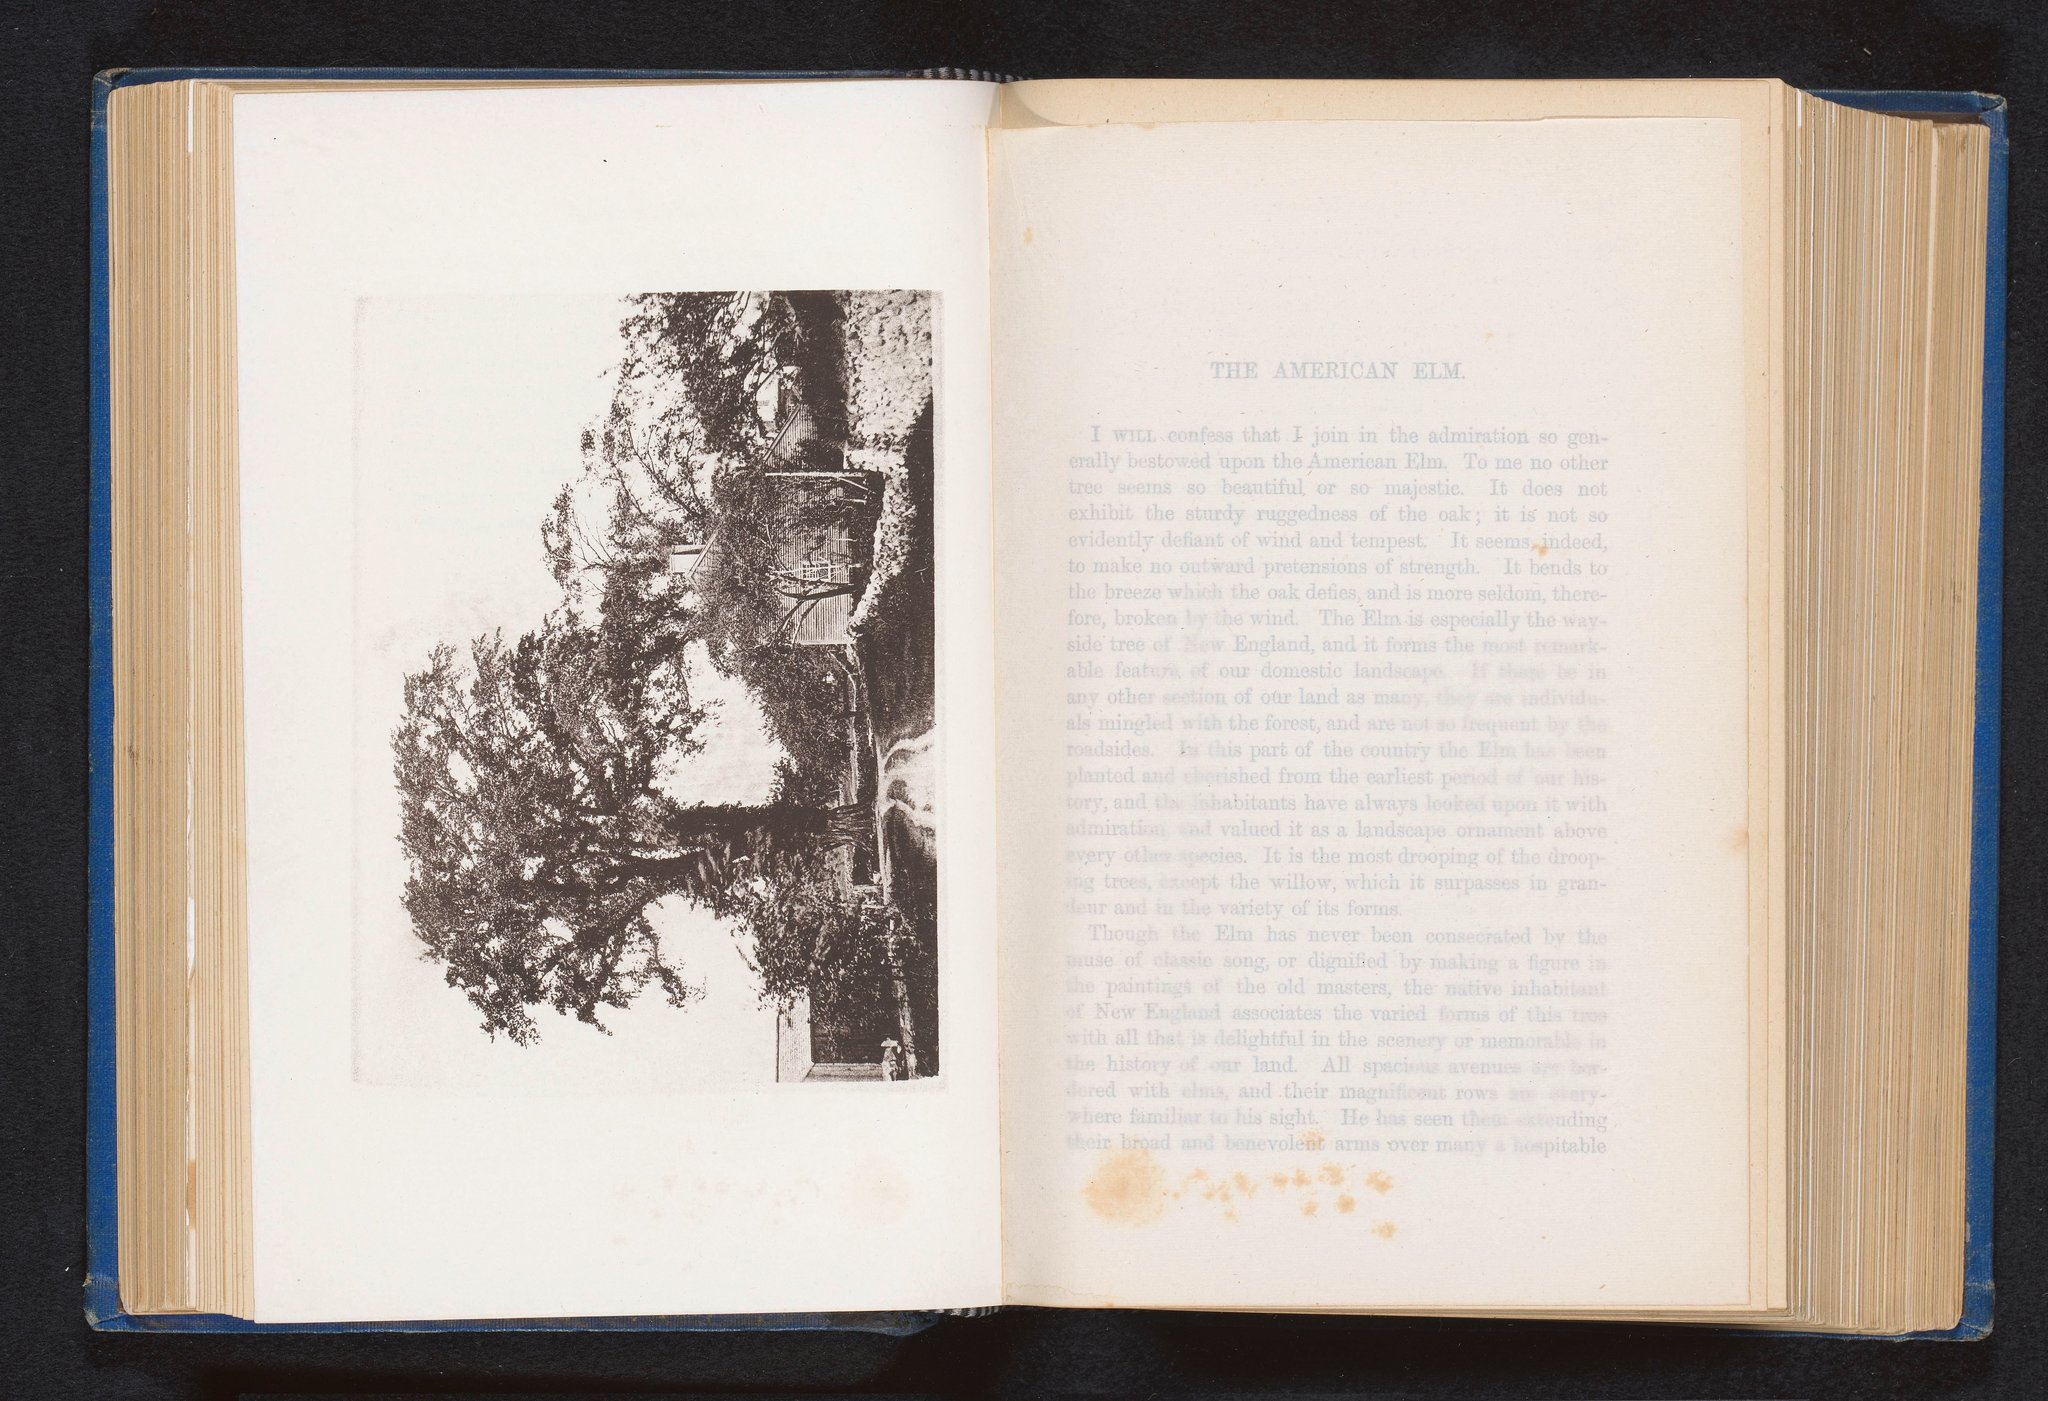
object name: photomechanical print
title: Landschap met een huis en een iep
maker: Anonymous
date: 1872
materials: paper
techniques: photograph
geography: beverly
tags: trees: elm, landscapes, façade (of house or building)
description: Prent op tweede ongenummerde pagina na pagina 84.